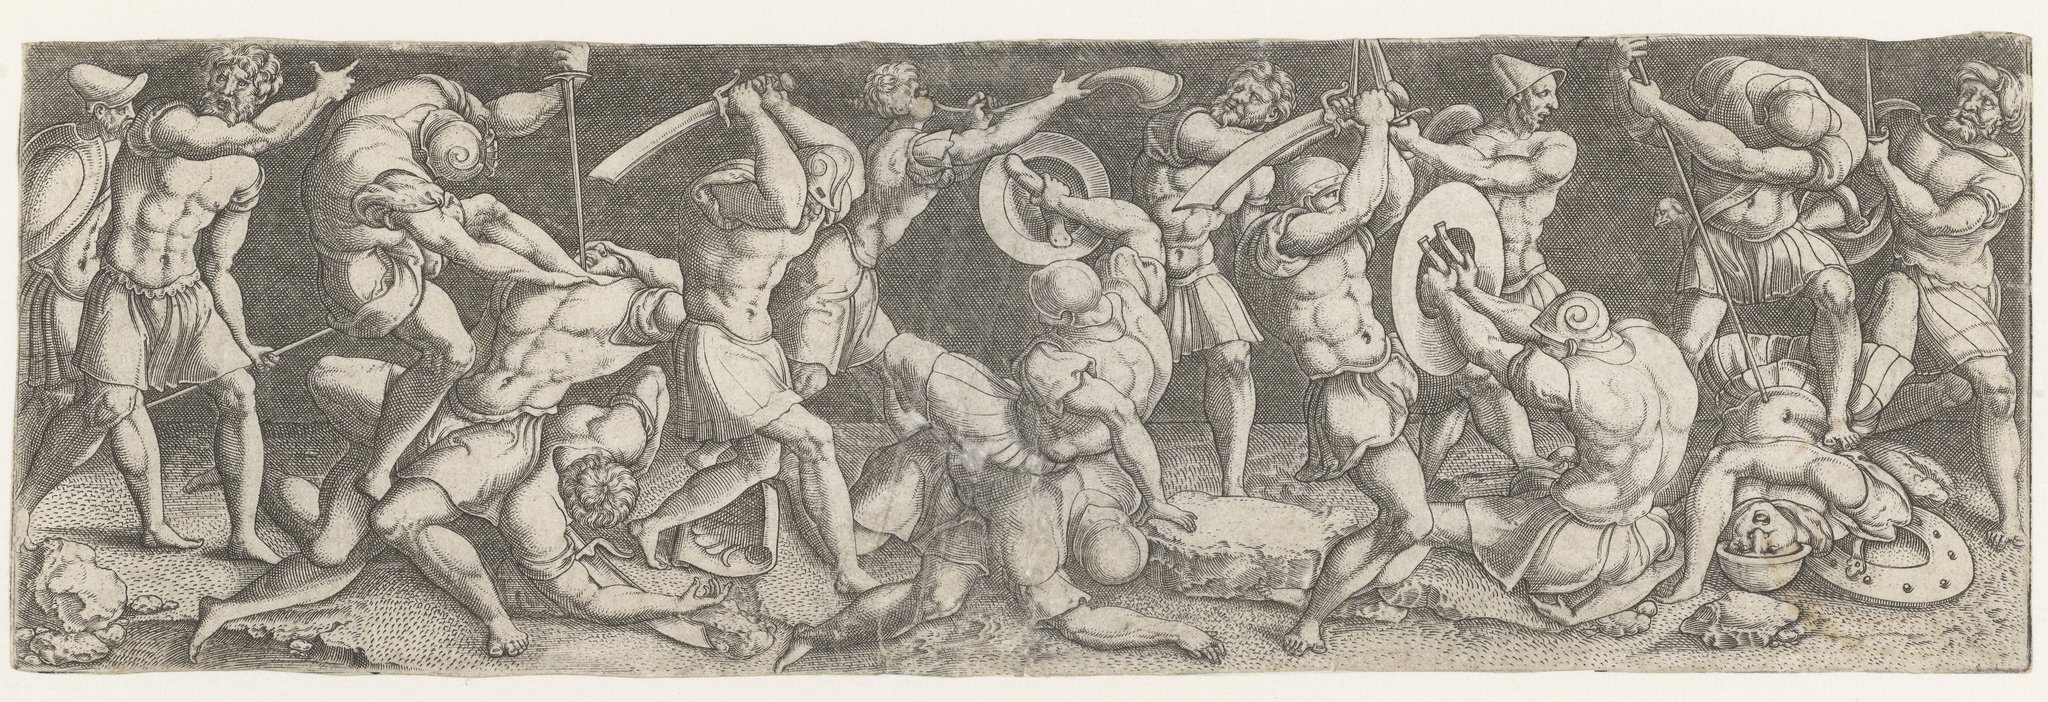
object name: print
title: Gevecht tussen Romeinse soldaten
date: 1520-1562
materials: paper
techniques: engraving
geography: low countries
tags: fighting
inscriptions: collector's mark: Lugt 240